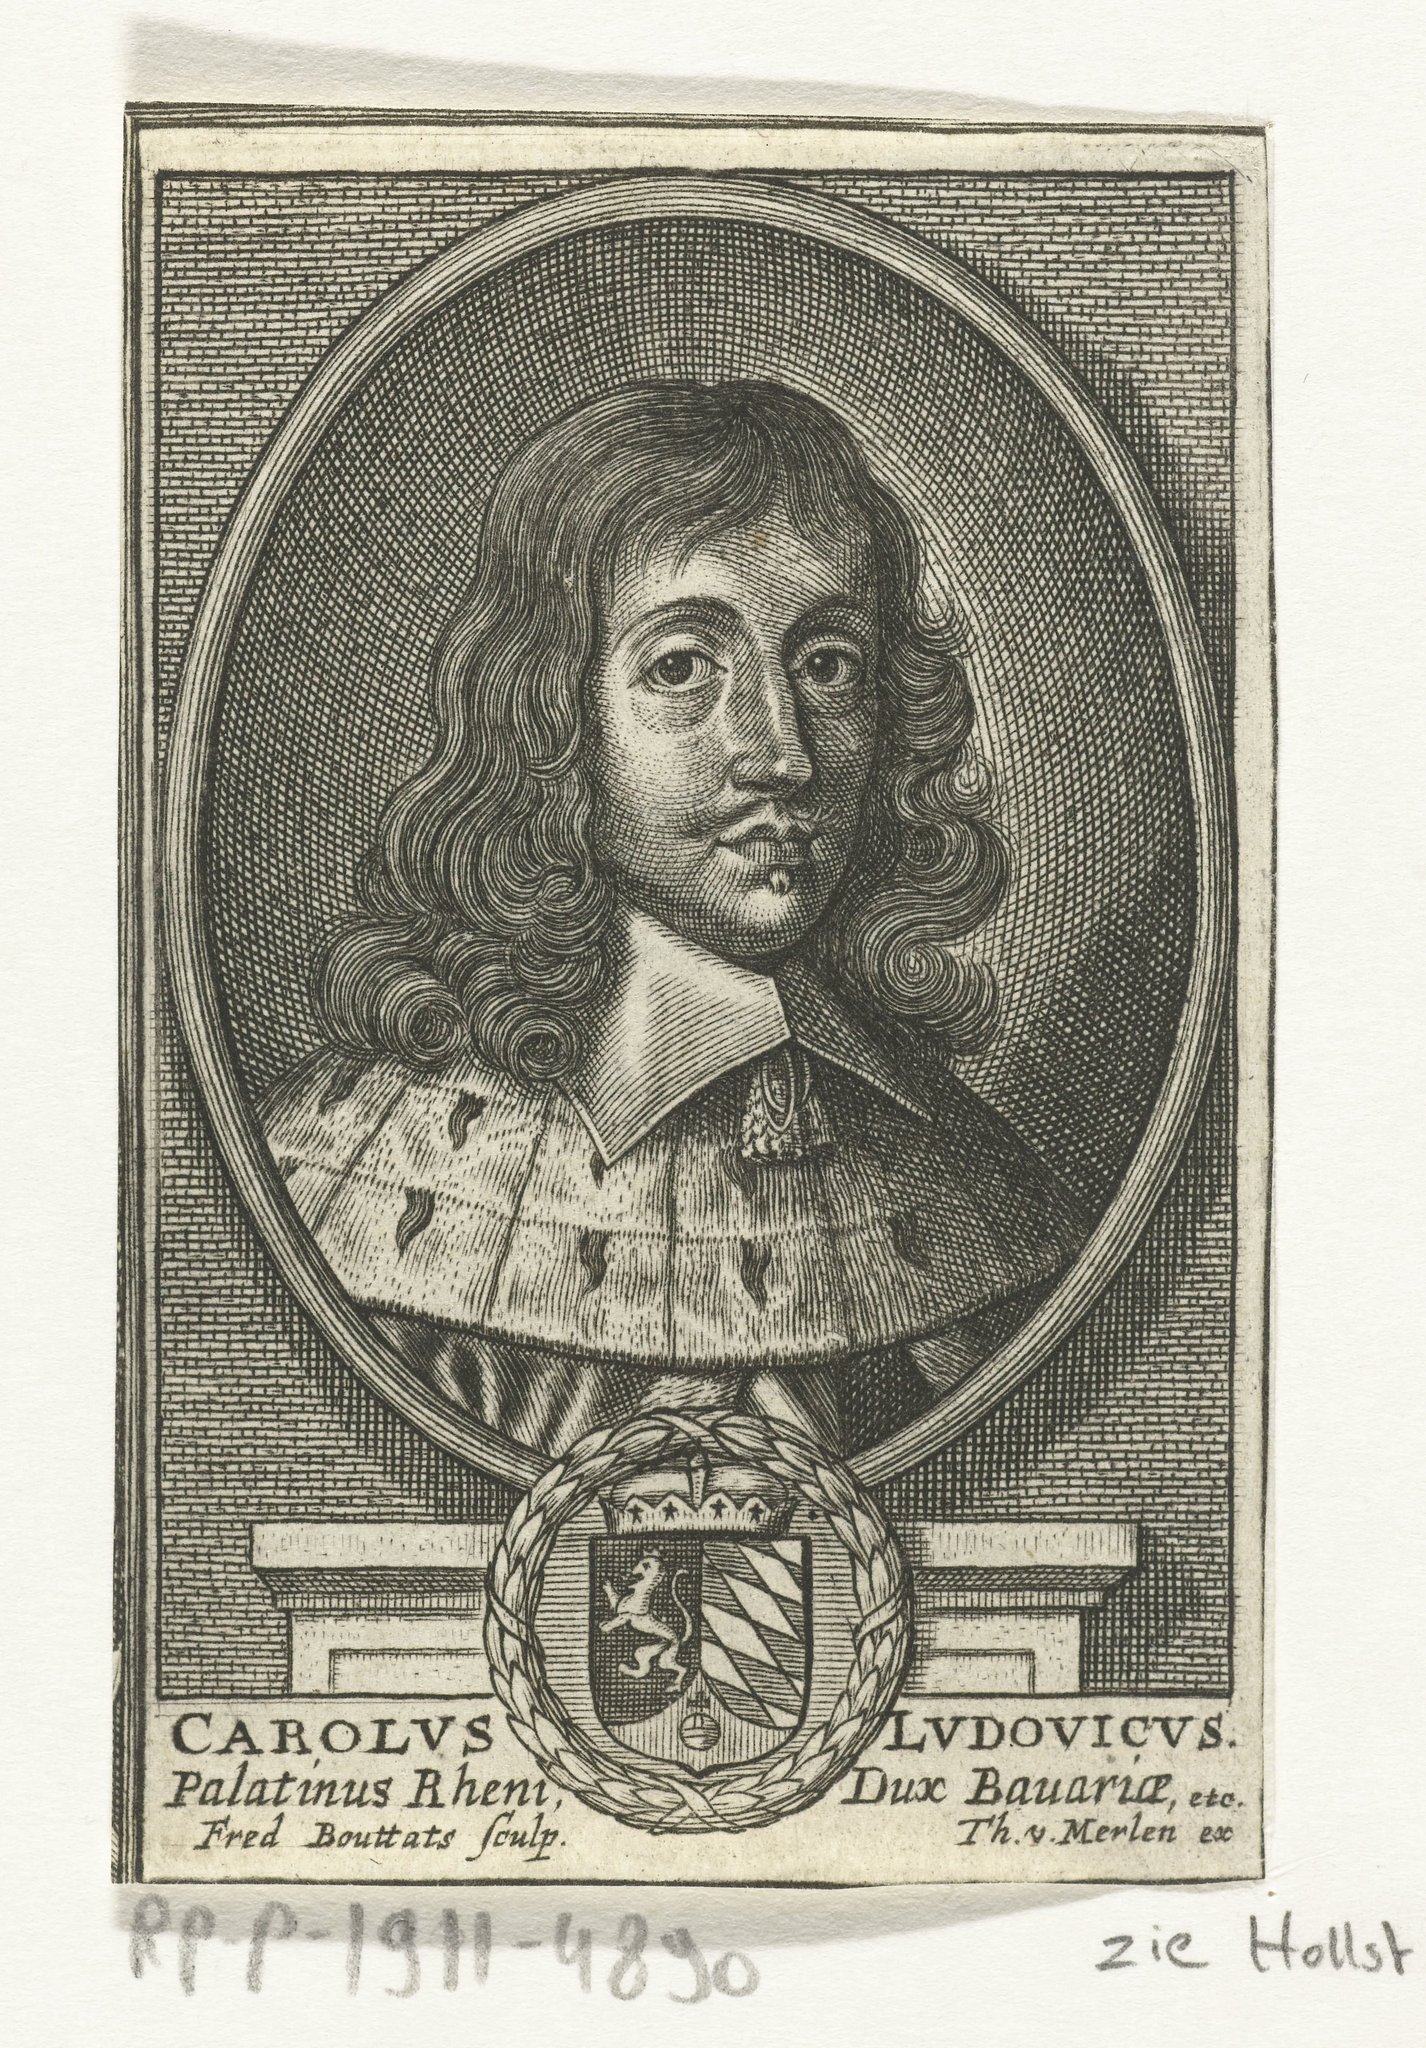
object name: print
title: Portret van Karel Lodewijk van de Palts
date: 1648-1676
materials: paper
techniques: engraving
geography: antwerp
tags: edingen, keurvorst, keurvorst van de palts karel lodewijk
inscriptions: collector's mark: Lugt 2228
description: Portret in een ovale lijst van Karel Lodewijk, keurvorst van de Palz. Buste naar rechts. Karel Lodewijk draagt een hermelijnen mantel. De prent heeft een Latijns onderschrift met de naam van de geportretteerde.